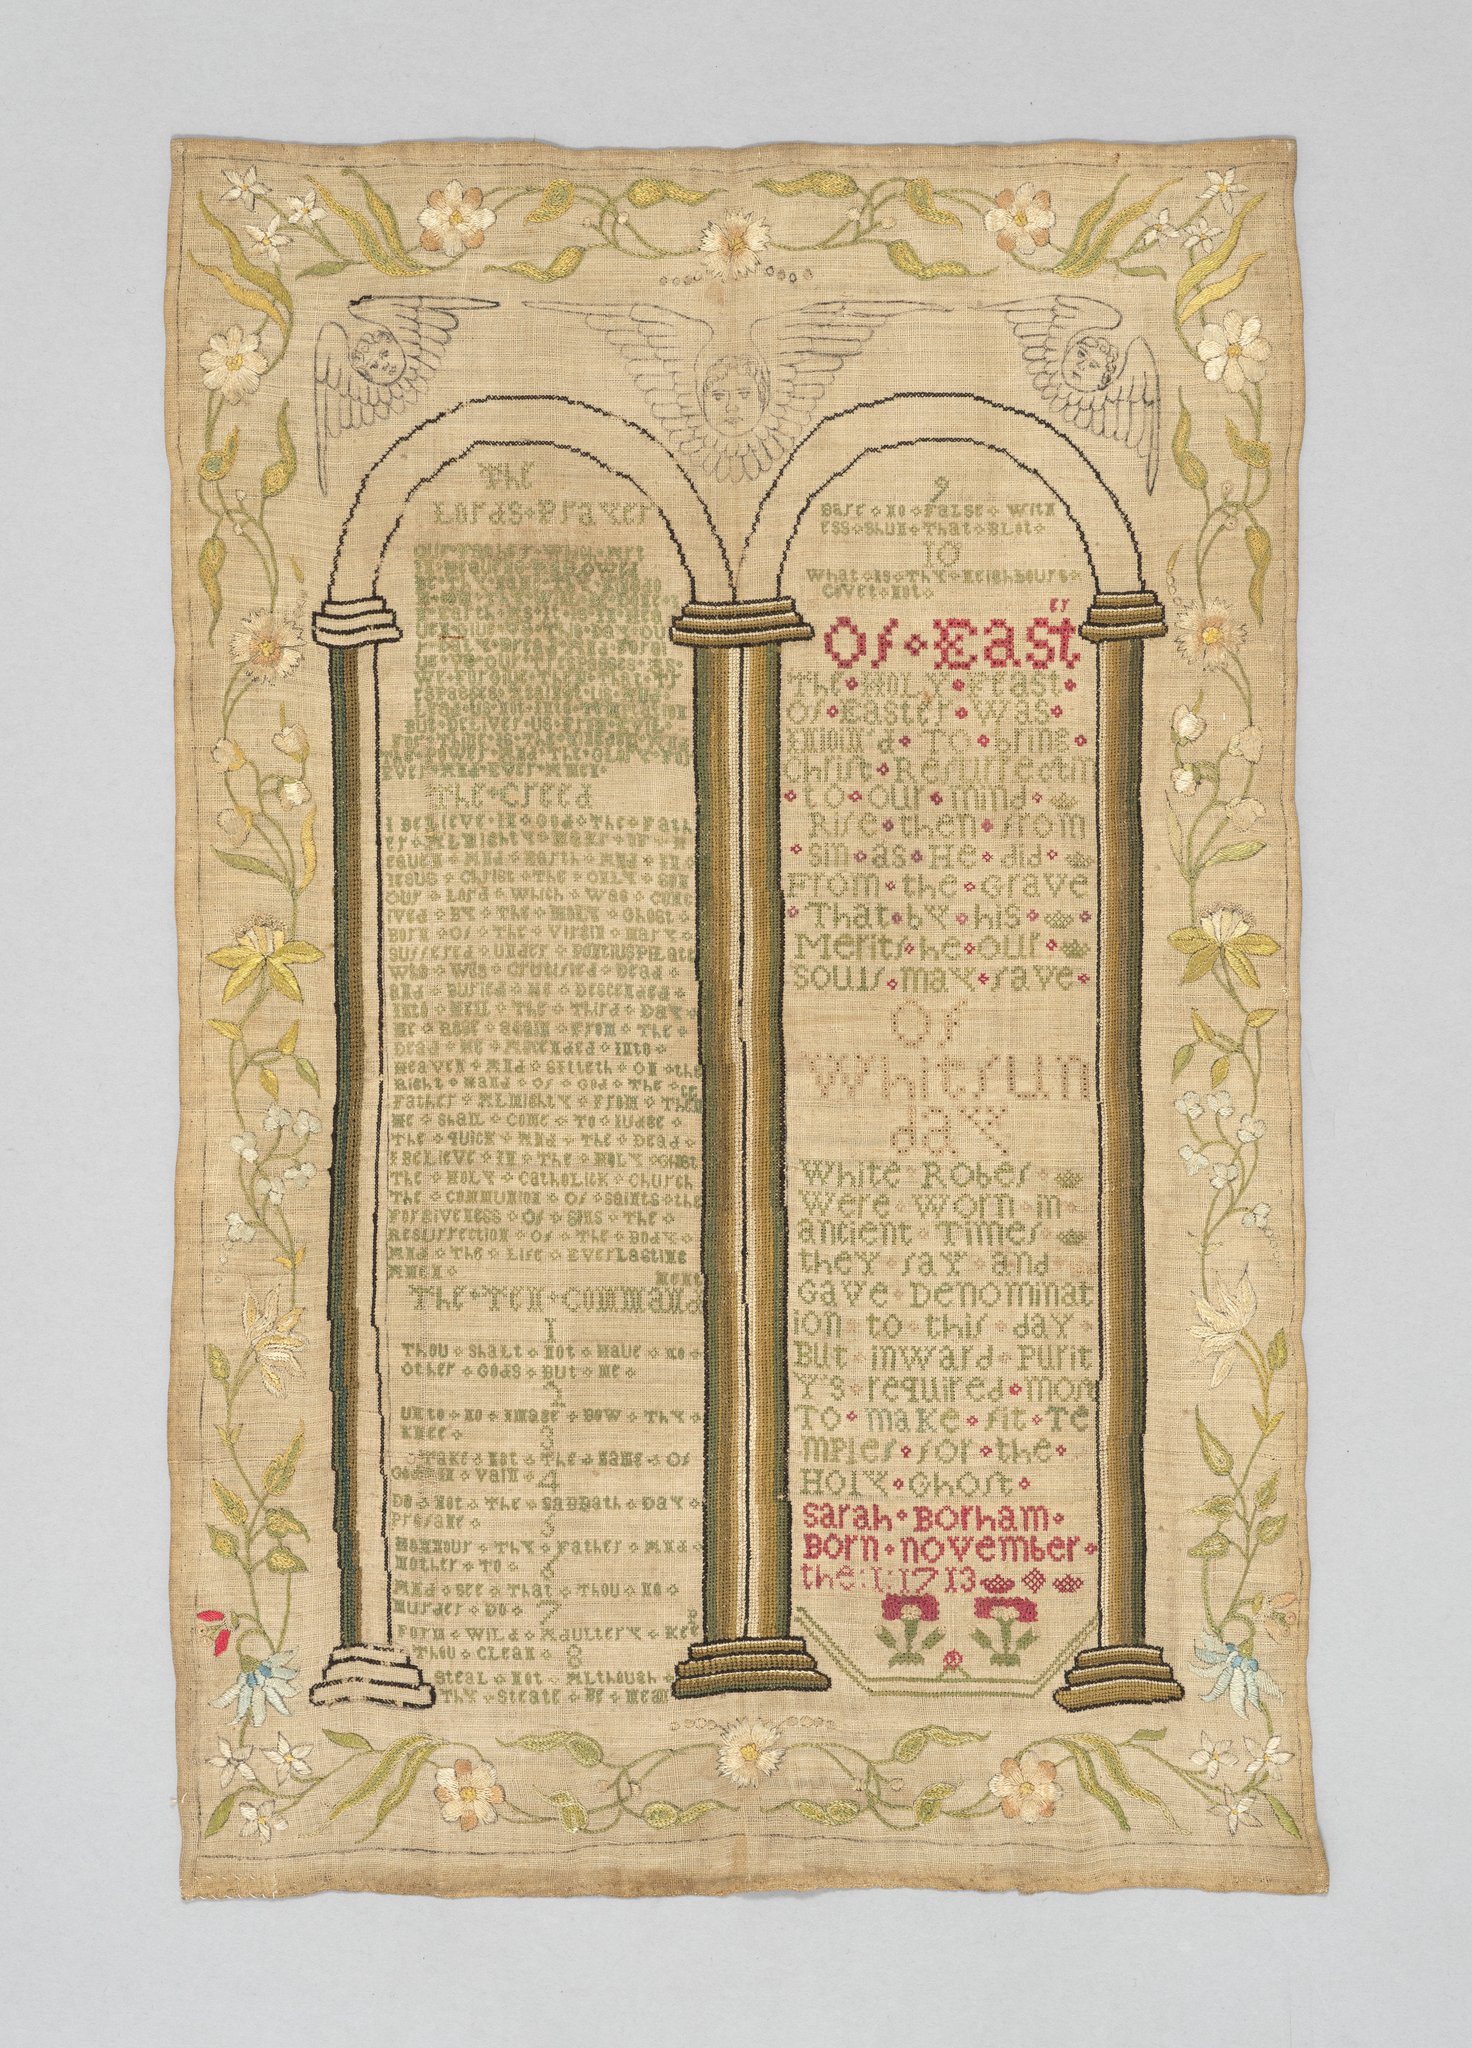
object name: sampler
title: Sampler with the Lord's Prayer, the Ten Commandments and other text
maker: sarah borham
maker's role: maker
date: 1701-1725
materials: linen, silk